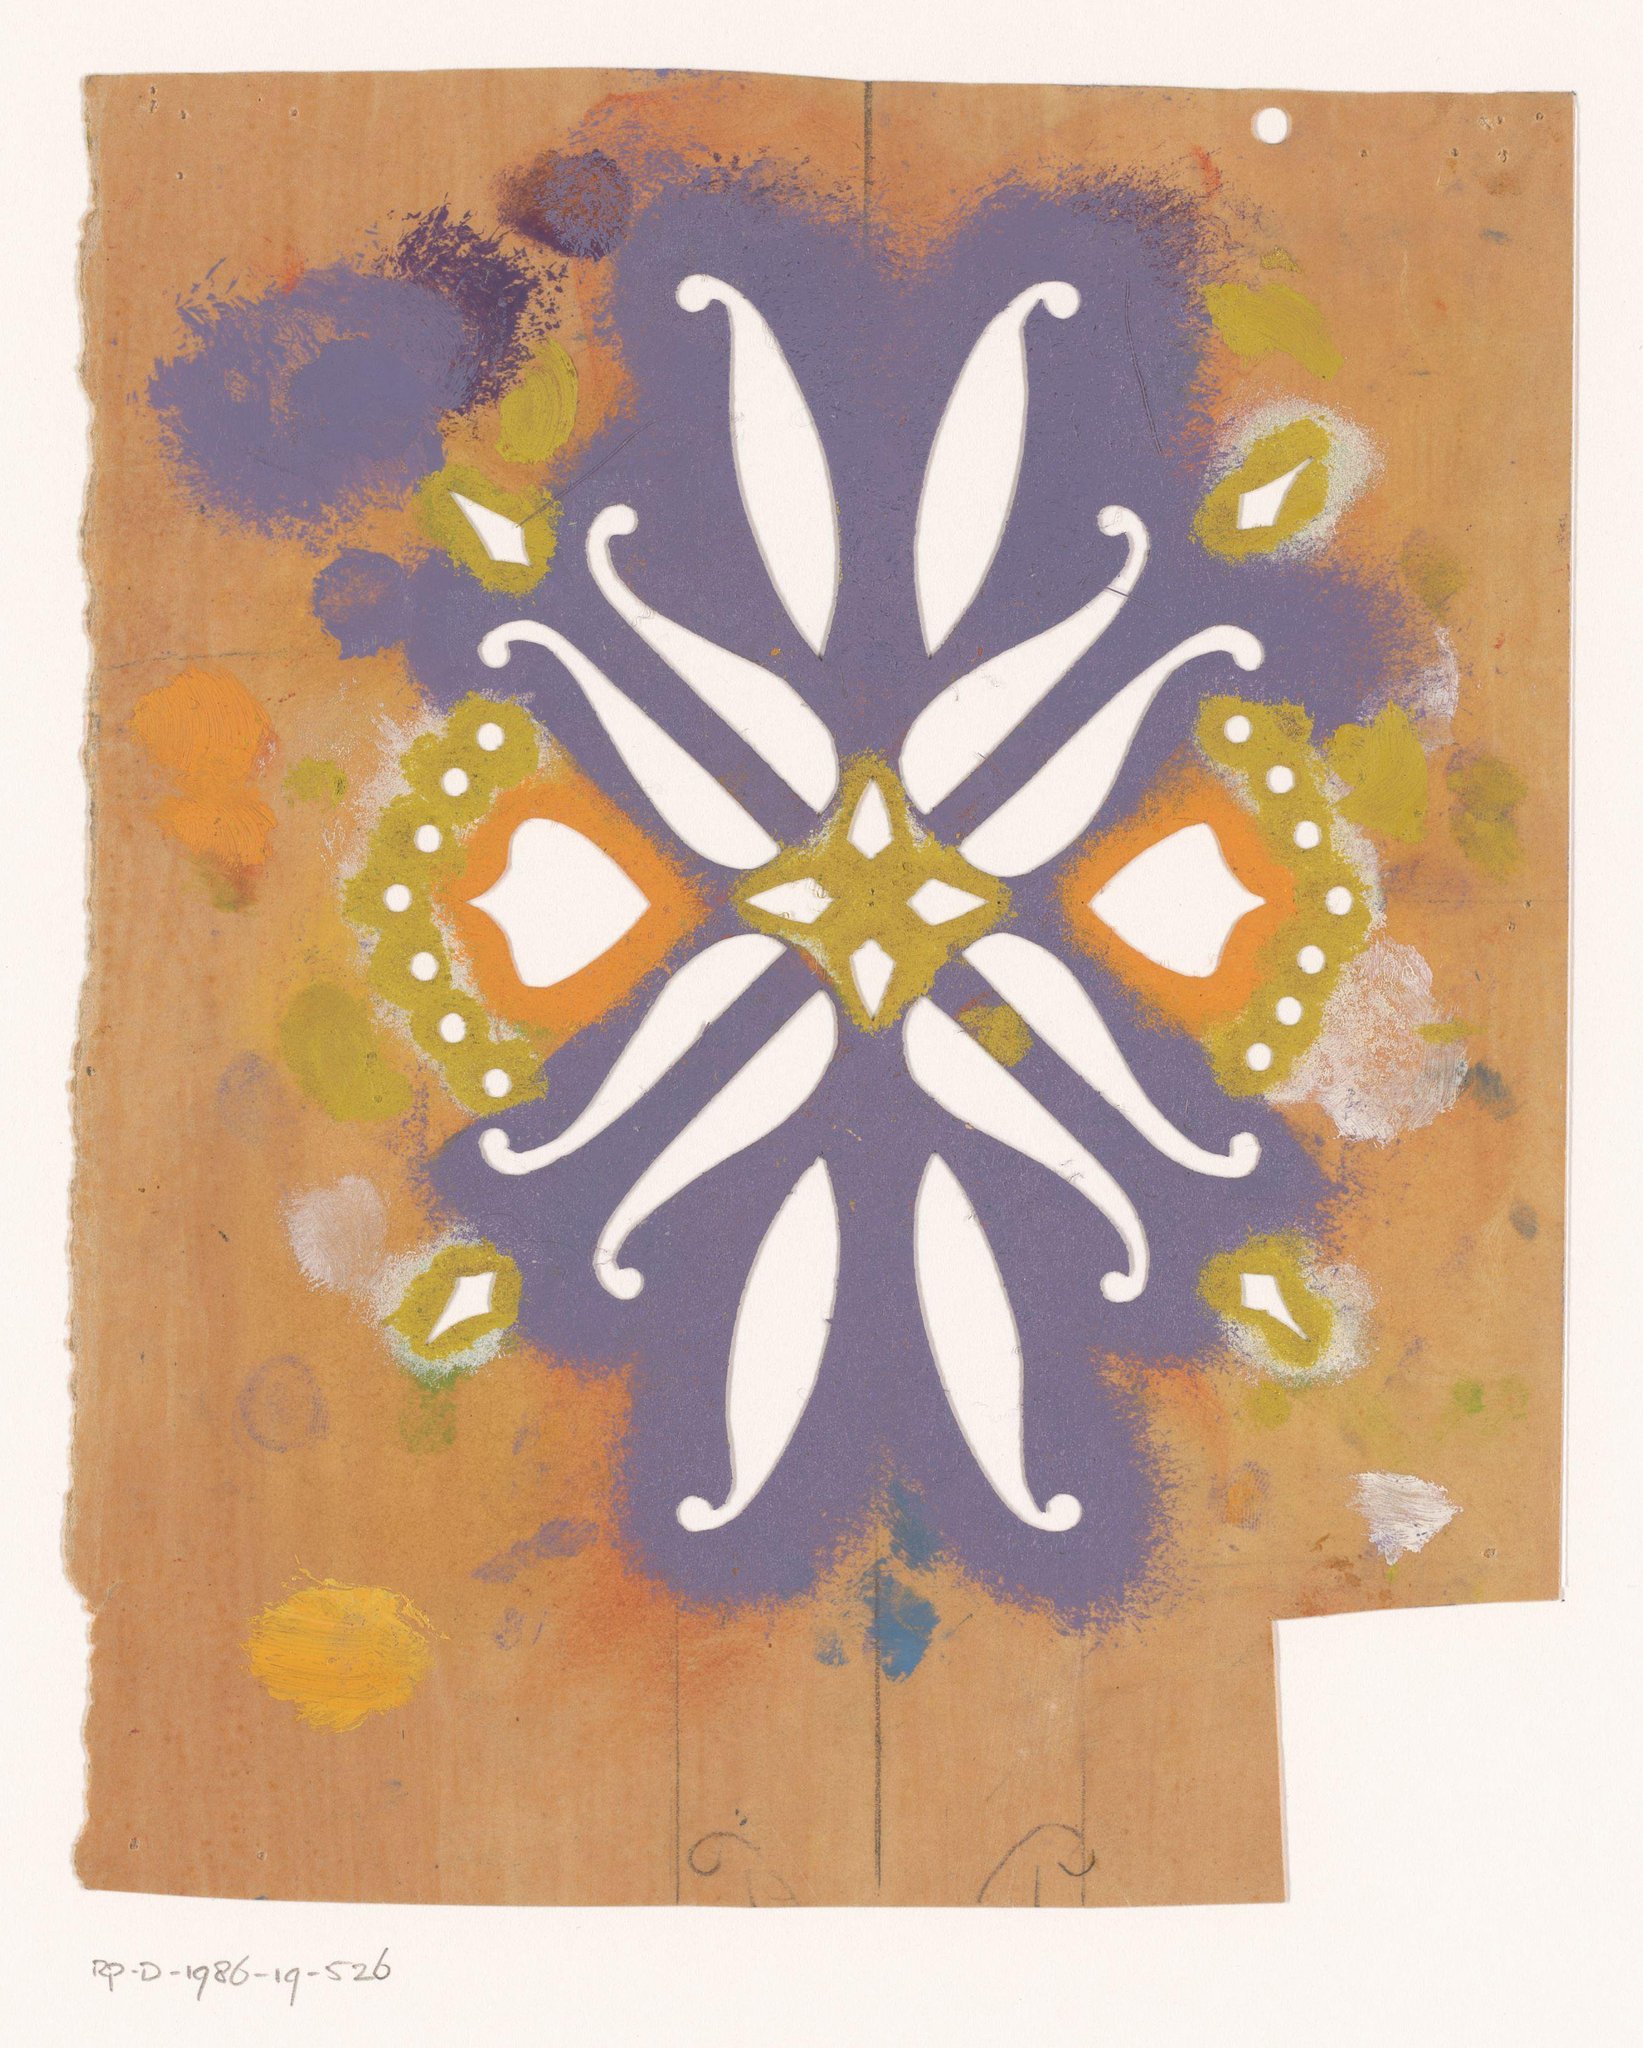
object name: template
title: Sjabloon met ornament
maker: reinier willem petrus de vries (1874-1953)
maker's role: draughtsman, print maker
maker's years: 1874-1953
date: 1884-1952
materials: paper, pencil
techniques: cutting, snipping